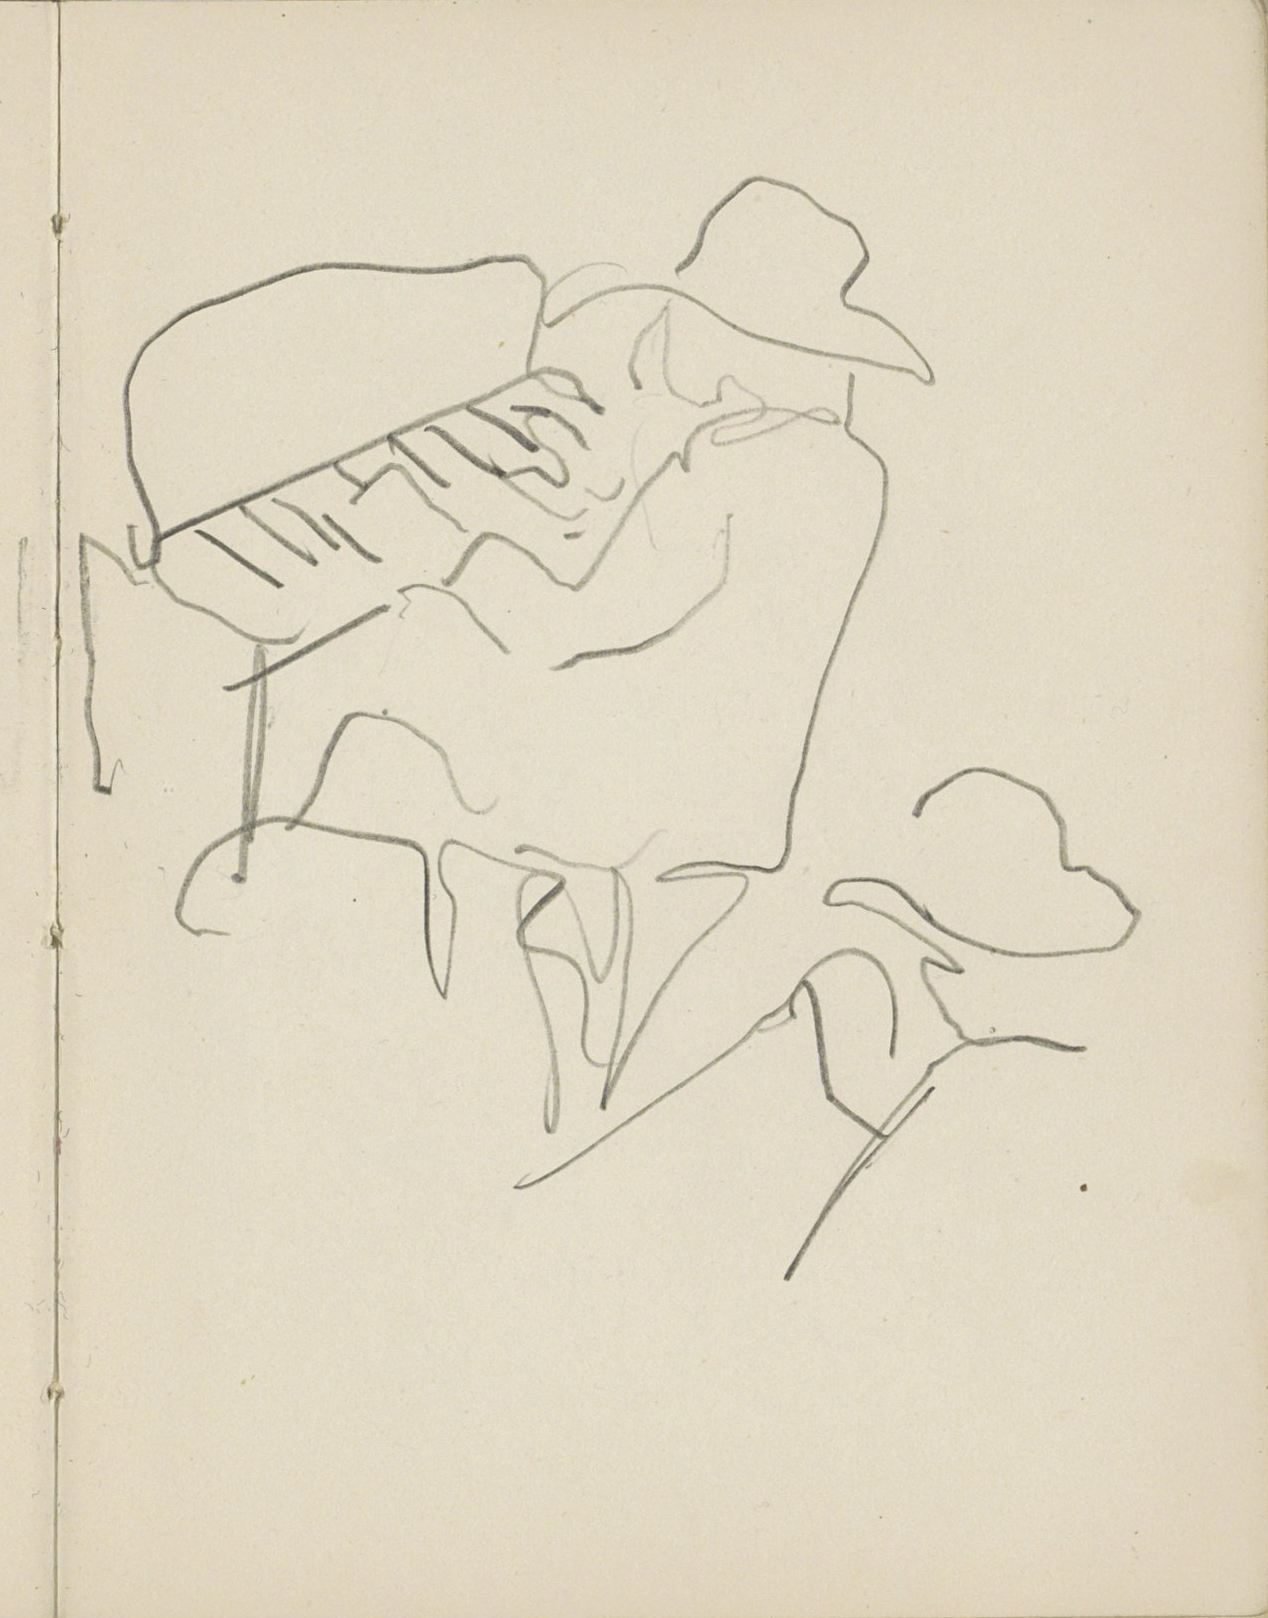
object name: sketchbook leaf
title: Pianospelende man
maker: reijer stolk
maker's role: draughtsman, print maker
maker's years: 1896-1945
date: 1906-1945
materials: paper, pencil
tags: one person playing keyboard instrument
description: Blad 3 recto uit een schetsboek met 69 bladen.